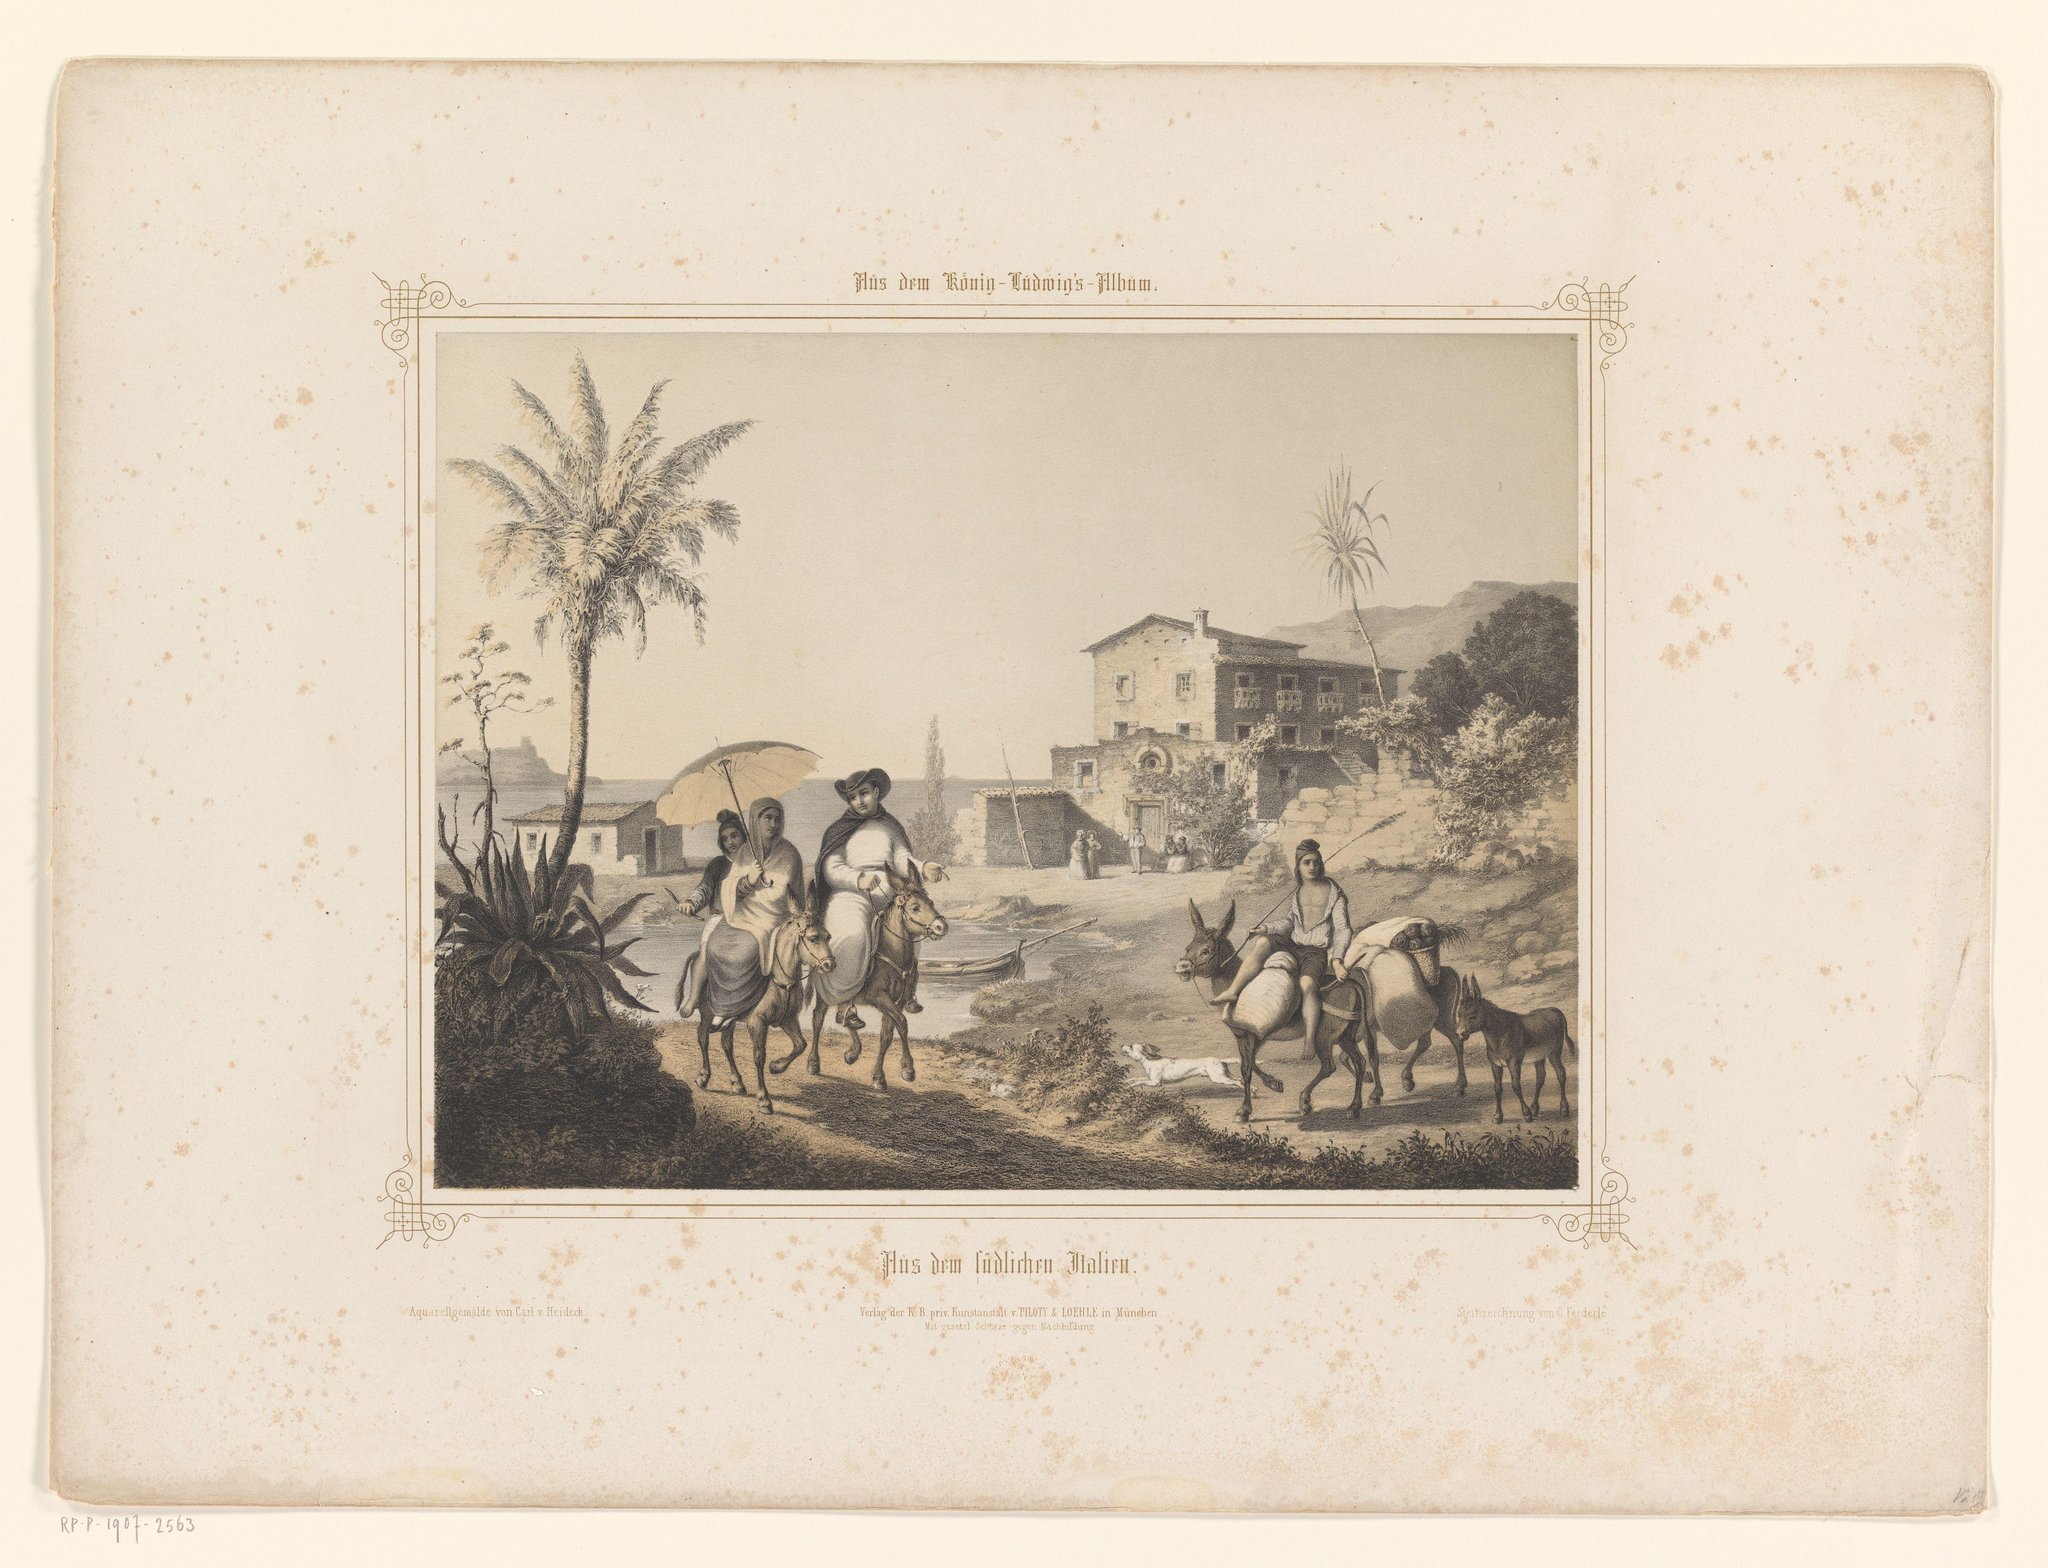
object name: print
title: König-Ludwigs Album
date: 1850-1859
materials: paper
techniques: lithograph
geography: munich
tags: riding a horse, ass, or mule; rider, horseman, 'en route', traveller under way, landscapes in the temperate zone (+ landscape with figures, staffage)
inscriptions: collector's mark: Lugt 2228, check stamp: ‘Piloty&Loehle, München’, : ‘Mit gesetzl Schutze gegen Nachbildung’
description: Prent afkomstig uit de serie 'Album Seiner Majestät des Königs Ludwig I. von Bayern', verschenen in verschillende afleveringen. De prenten gaan terug op het album dat Lodewijk I van Beieren op 9 oktober 1850 kreeg overhandigd van verschillende kunstenaars.